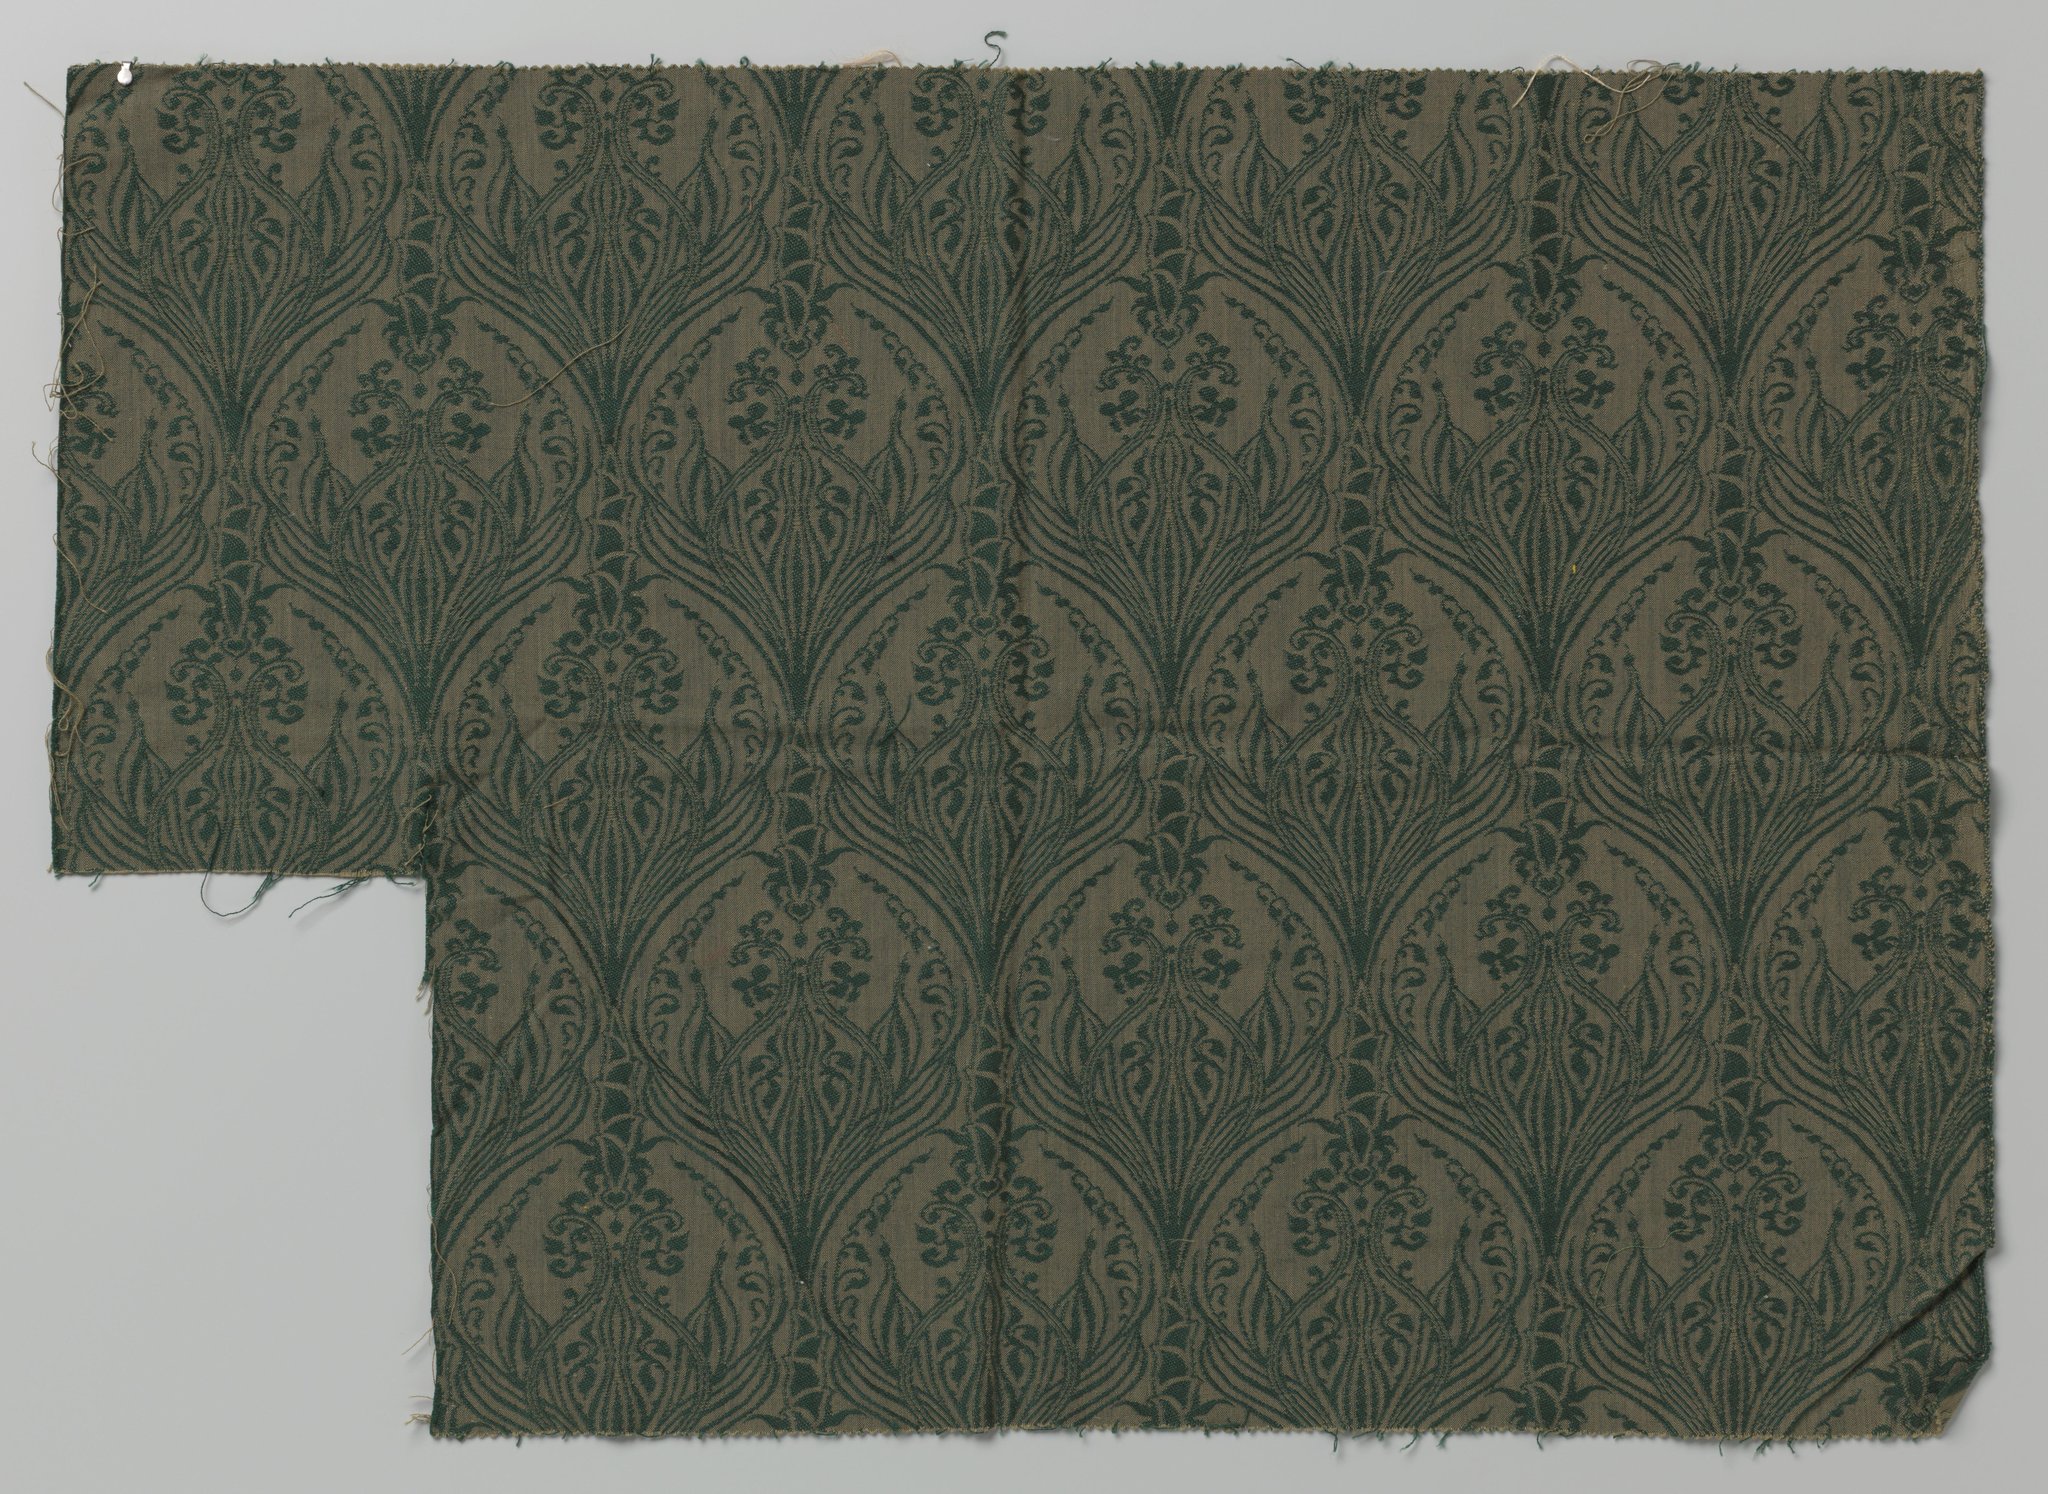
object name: coupon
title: Bespanningsstof met hyacinten, groene inslag op beige ketting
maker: theo nieuwenhuis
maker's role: designer, draughtsman, print maker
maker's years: 1866-1951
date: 1909-1924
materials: cotton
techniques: jacquard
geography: netherlands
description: Bespanningsstof van jacquardeweven katoen met een patroon van hyacinten in spitsovaalvormen. Groene inslag op beige ketting. Linksonder een hoek van 19 x 13 cm uitgeknipt. Papieren label aan de achterzijde vermeldt “1876”, mogelijk het dessinnummer.